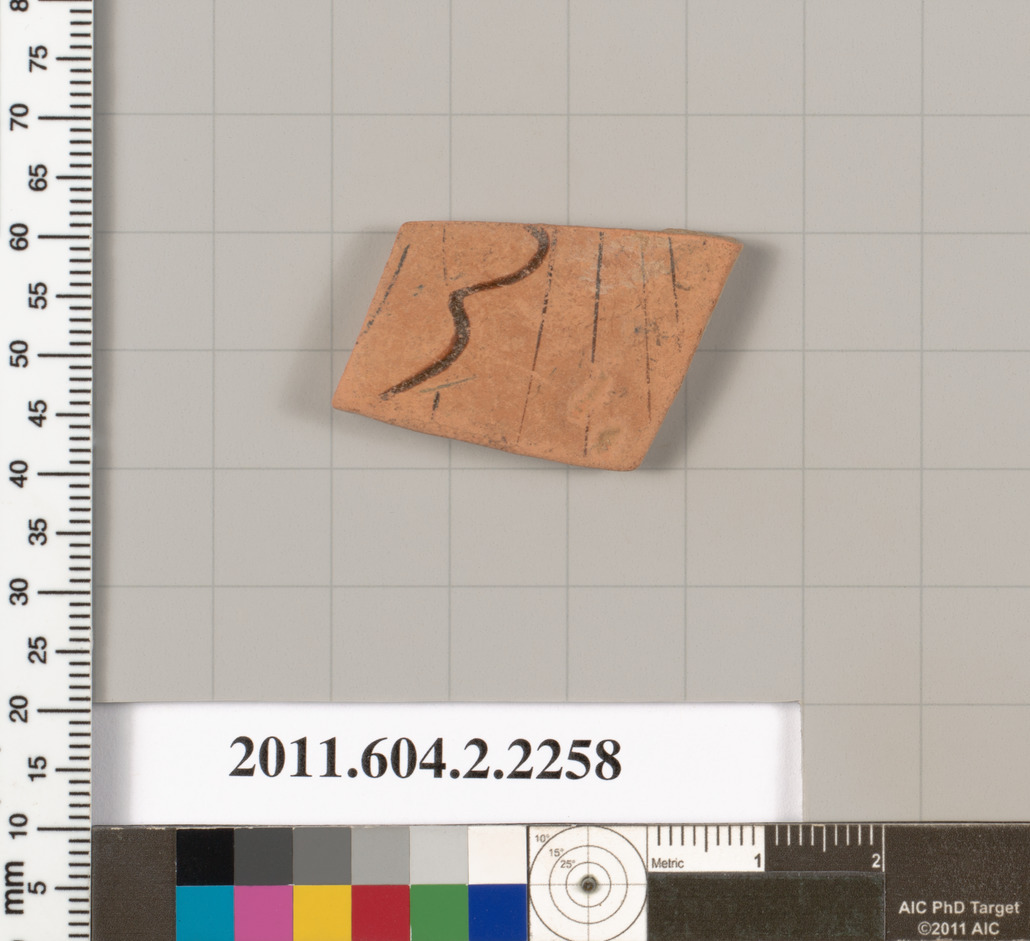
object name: pot fragment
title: Terracotta fragment of a pot; unglazed on the inside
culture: greek, attic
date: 460-440 BCE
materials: terracotta